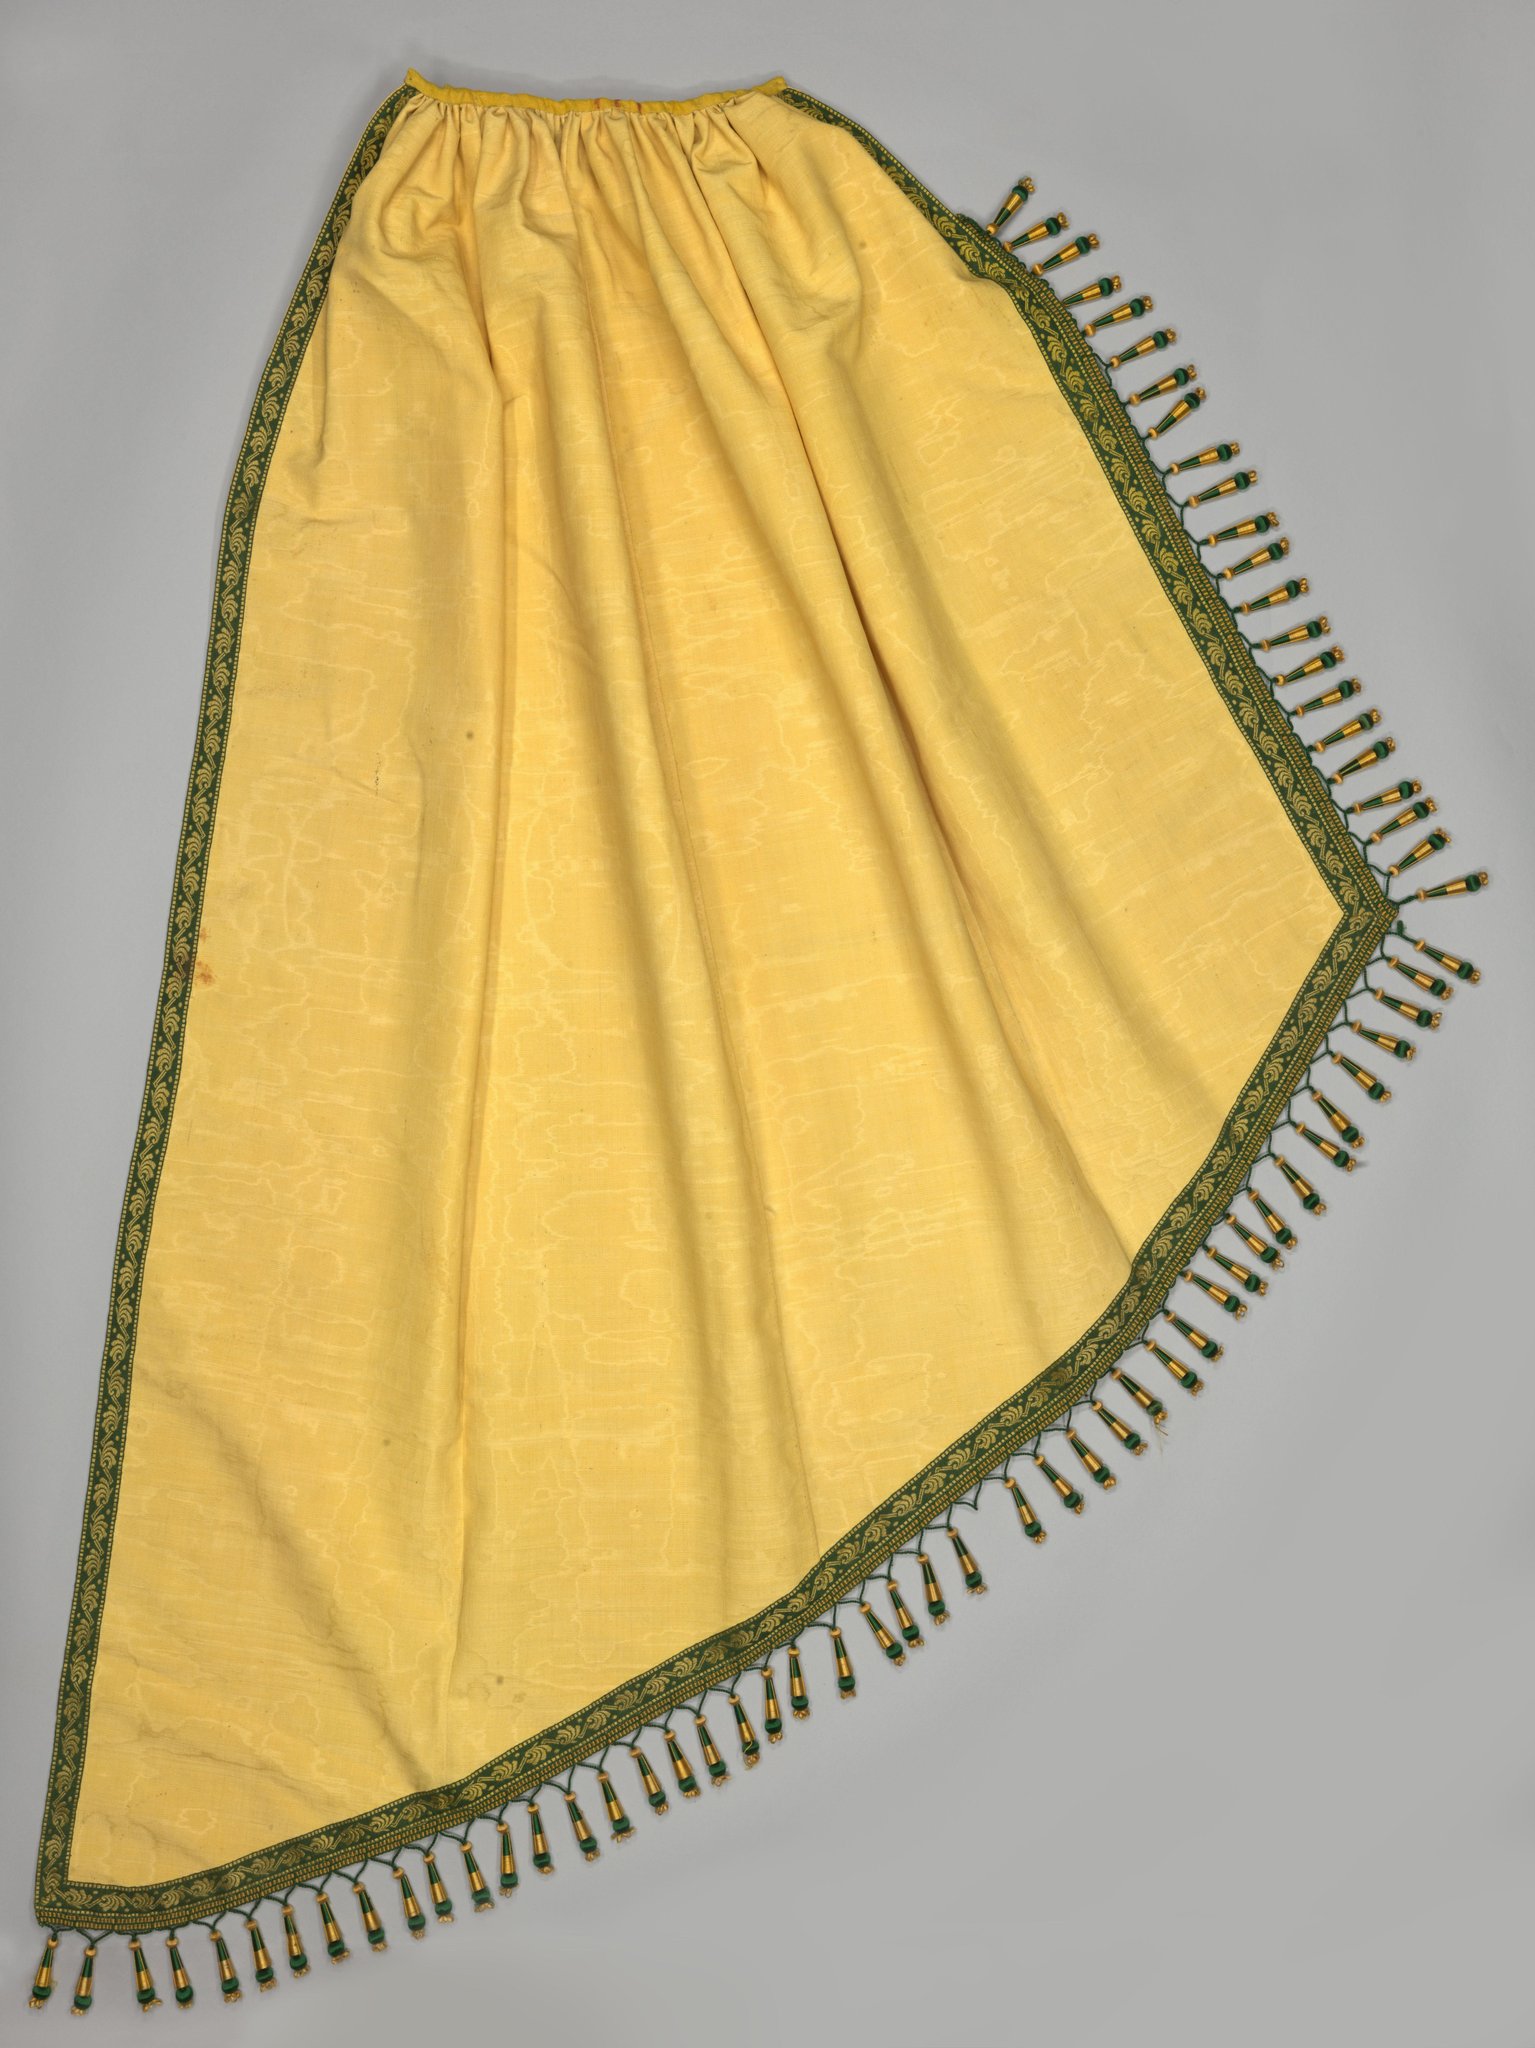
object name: bed covering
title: Hoekkap van een bedgarnituur van gele gewaterde wol met groen passement en afhangende klosjes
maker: Anonymous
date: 1795-1815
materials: silk, wool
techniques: moire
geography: northern netherlands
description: Een hoekkap voor bovenaan een gordijnstok, behorend bij bedgarnituur van gele gewaterde zijde, omboord met groen passement met een geel motief en met een groen en geel boordsel met afhangende klosjes die met gele en groene zijde zijn omwonden.